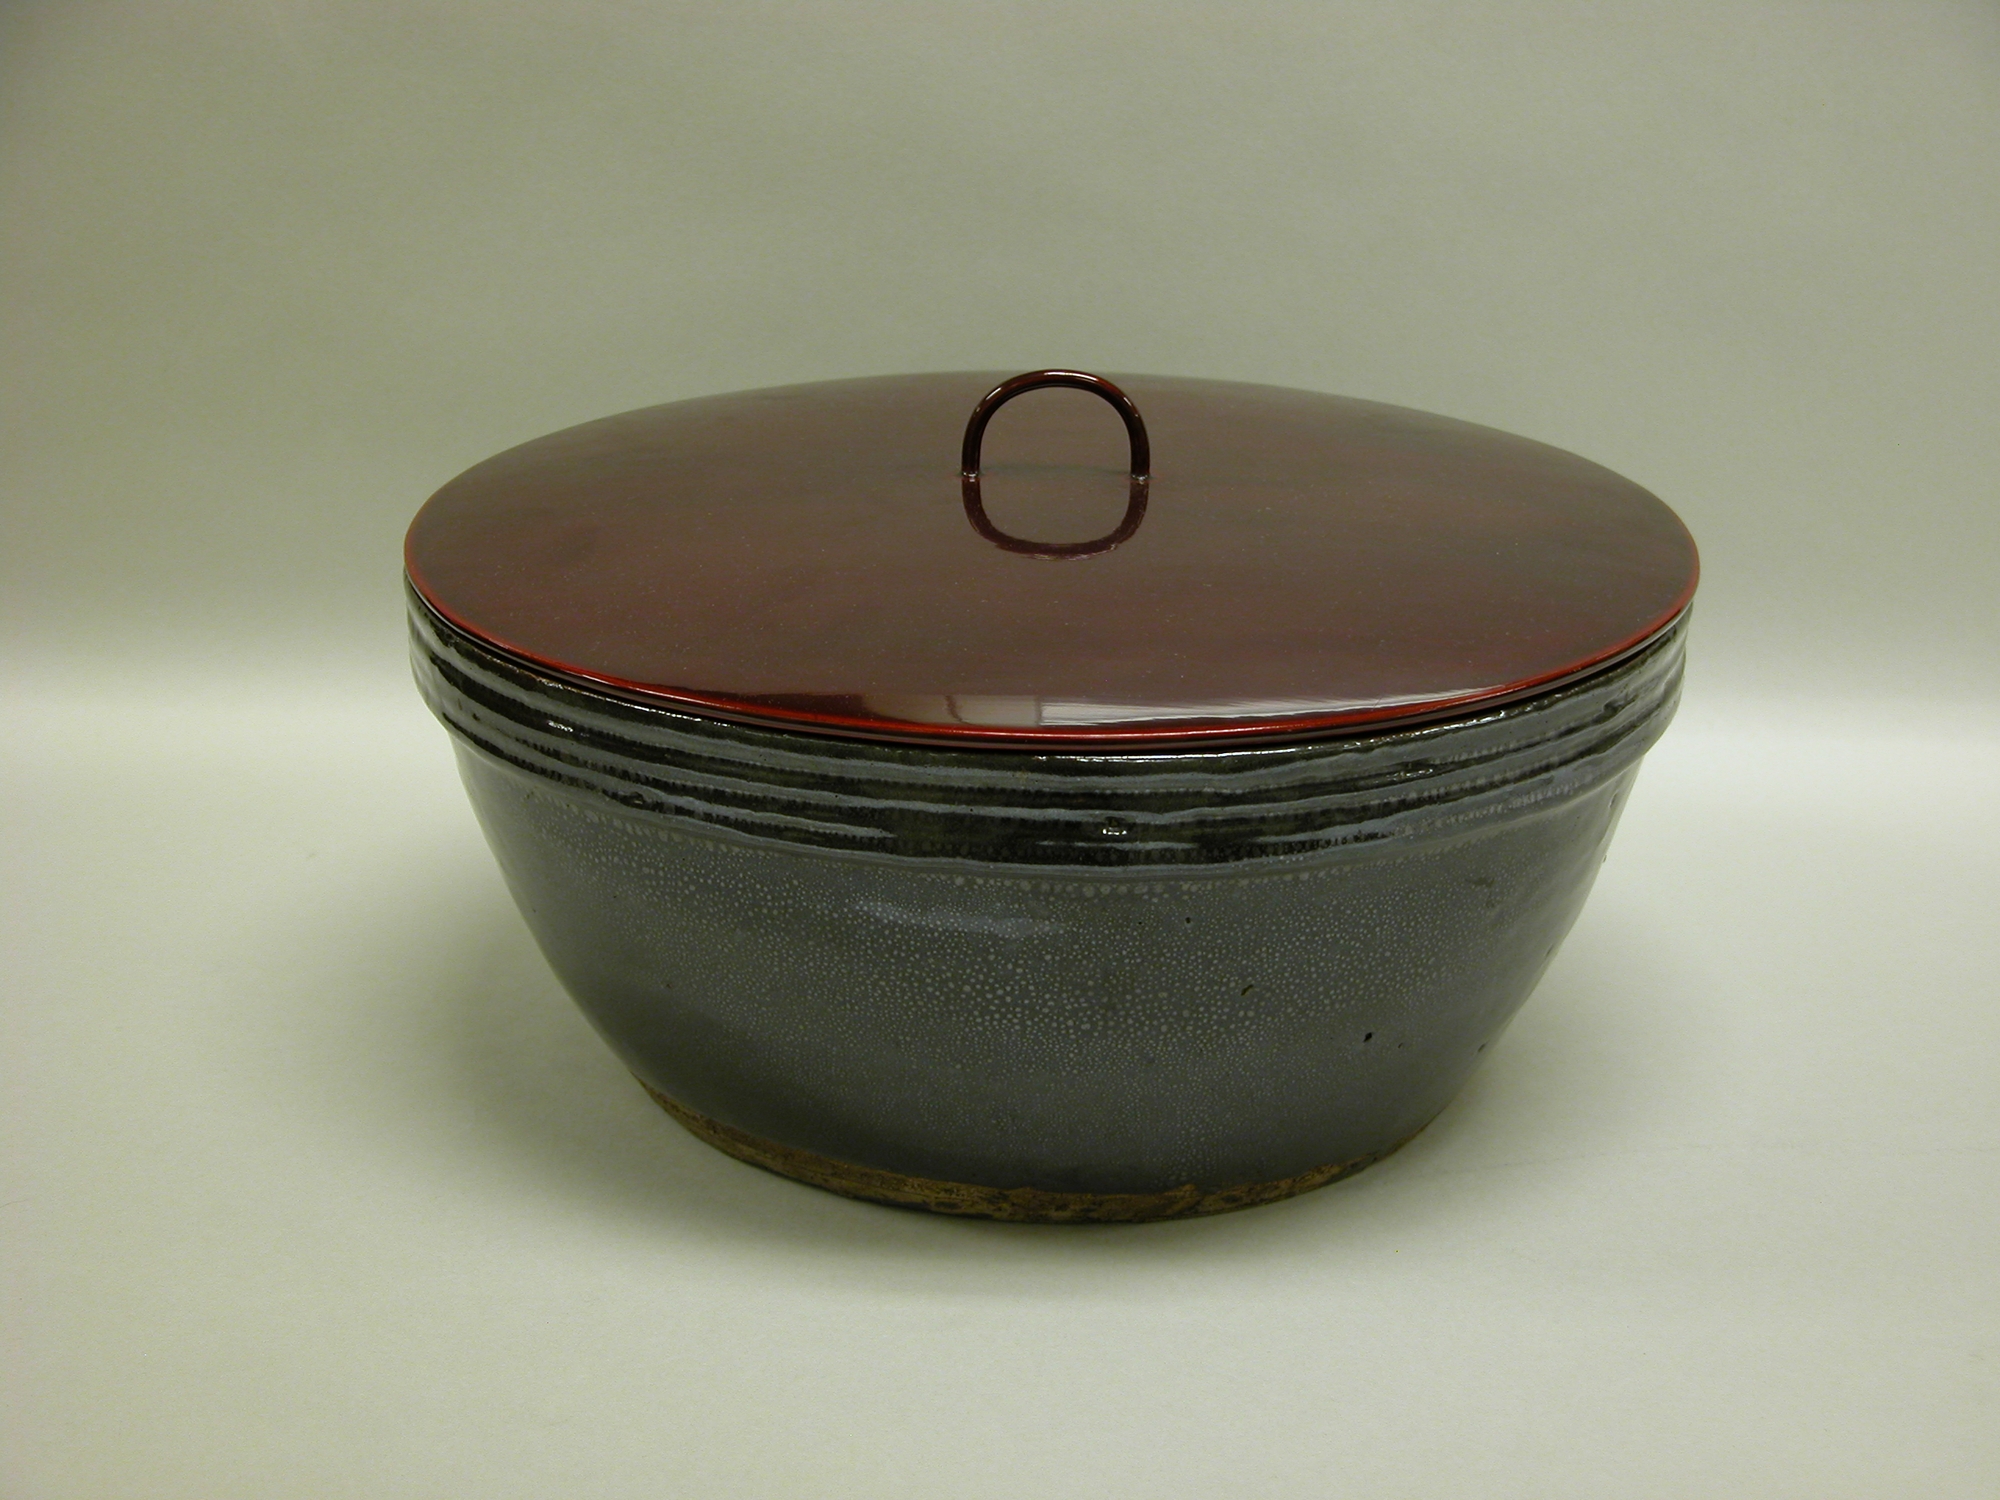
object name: water container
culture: chinese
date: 1101-1300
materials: glaze, lacquer, oil, stoneware